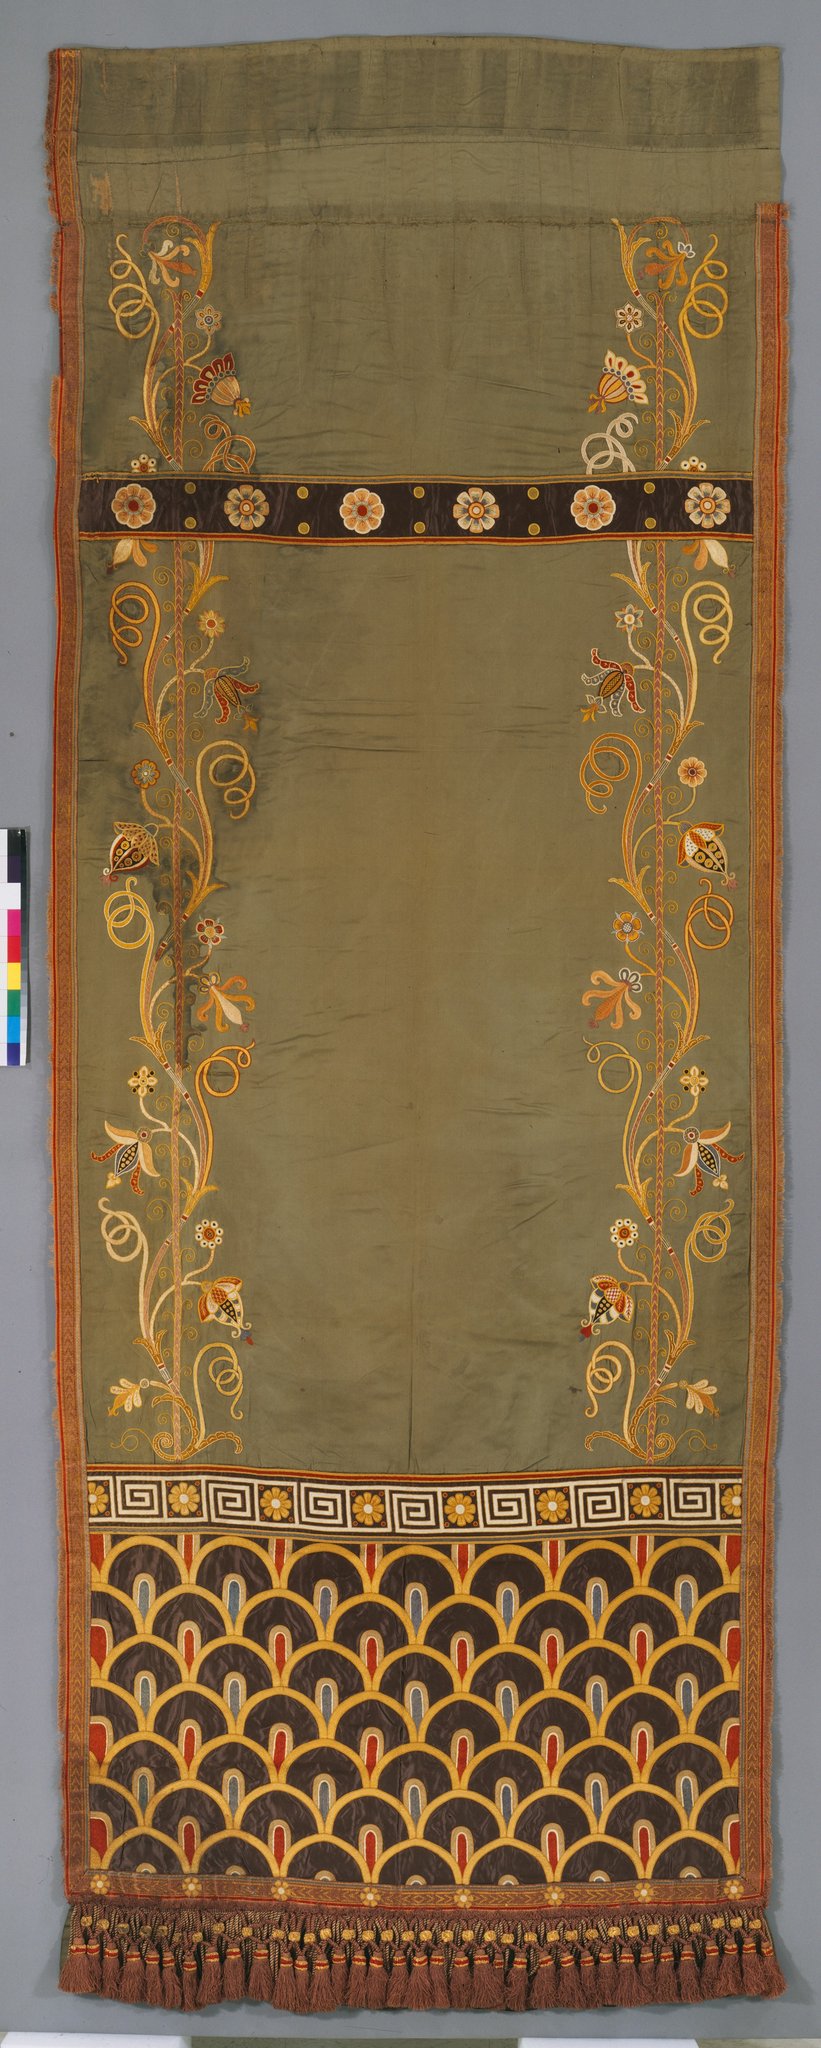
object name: curtain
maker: sir lawrence alma-tadema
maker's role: designer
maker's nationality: british, born the netherlands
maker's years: 1836-1912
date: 1885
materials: silk